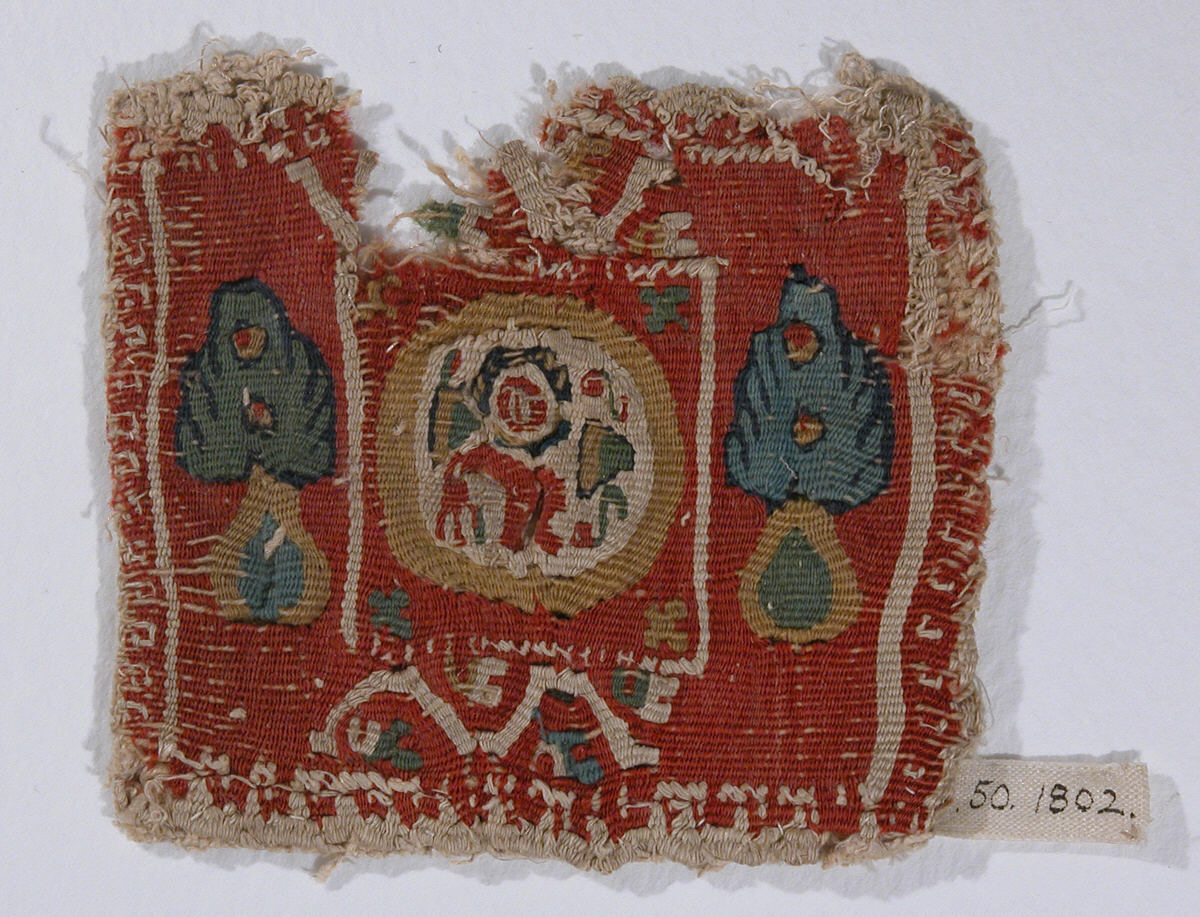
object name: square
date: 401-600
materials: linen, wool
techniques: weave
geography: egypt